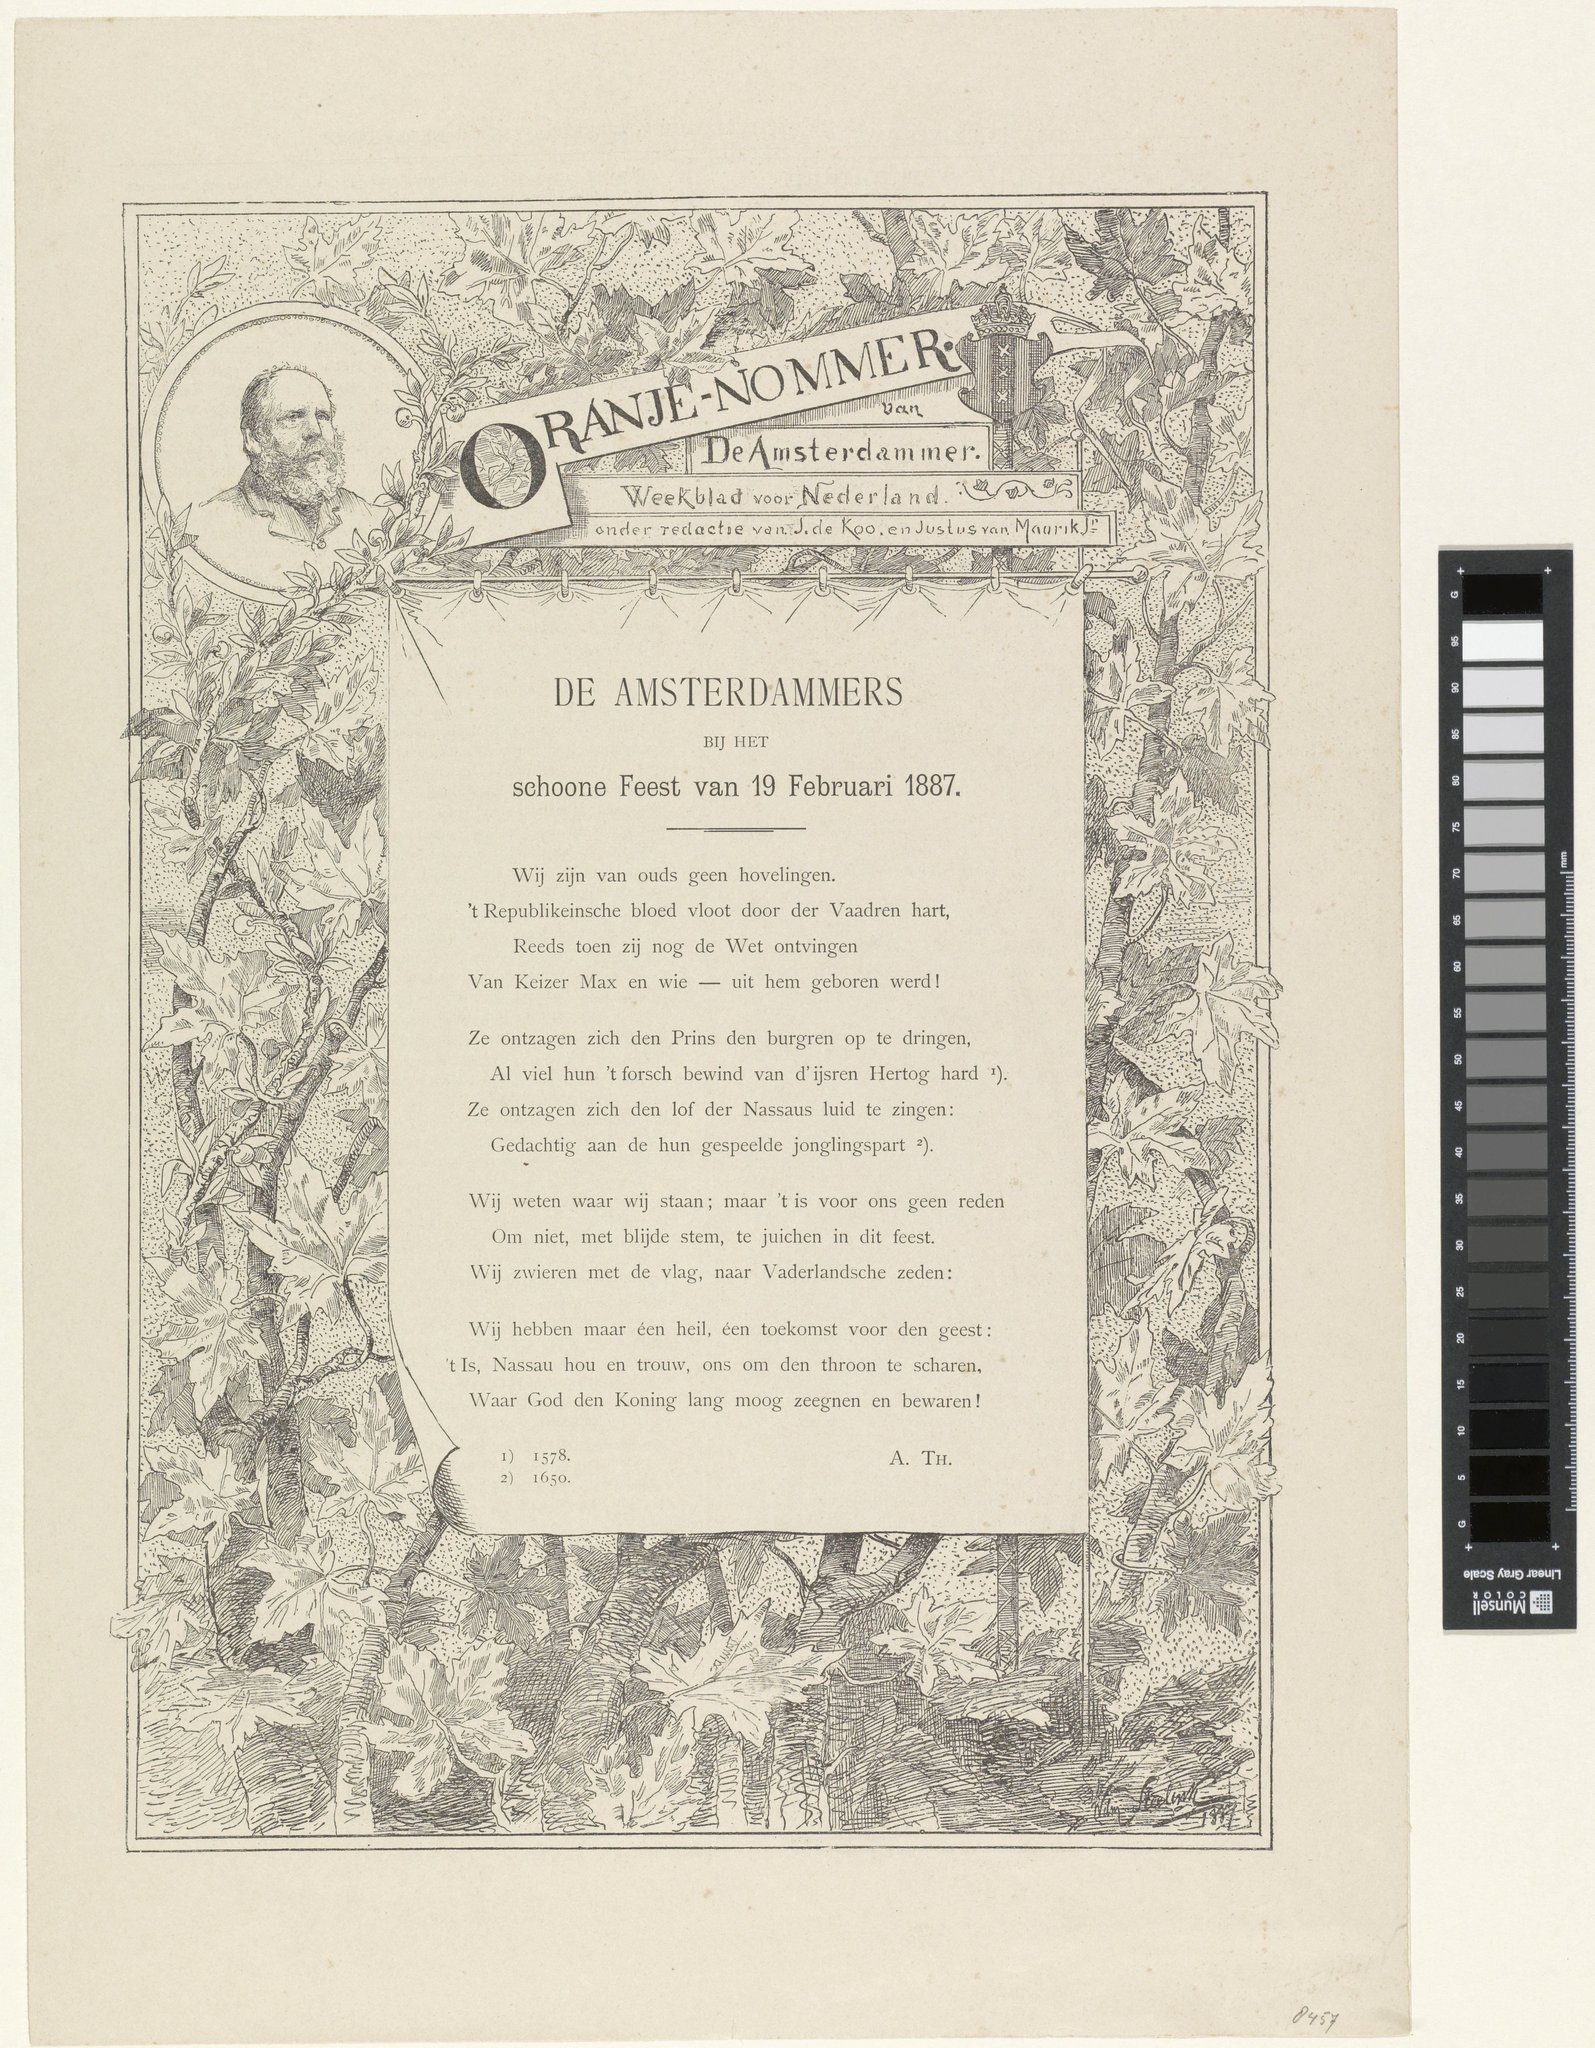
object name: print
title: Oranje-nommer van De Amsterdammer. Weekblad voor Nederland / De Amsterdammers bij het schoone Feest van 16 februari 1887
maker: willem steelink (ii)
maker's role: draughtsman, print maker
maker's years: 1856-1928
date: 1887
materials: paper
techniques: lithograph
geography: amsterdam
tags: brussels, willem iii (koning der nederlanden), amsterdam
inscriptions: collector's mark: Lugt 2228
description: Blad uit het Oranjenummer van het weekblad De Amsterdammer met een vers op de inwoners van de stad Amsterdam ter gelegenheid van het feest aldaar gehouden op 19 februari 1887 bij de viering van de 70ste verjaardag van de koning. Het tekstdeel met het vers omgeven door gebladerte en linksboven een portret van koning Willem III. Bedrukt met tekst op de achterzijde.